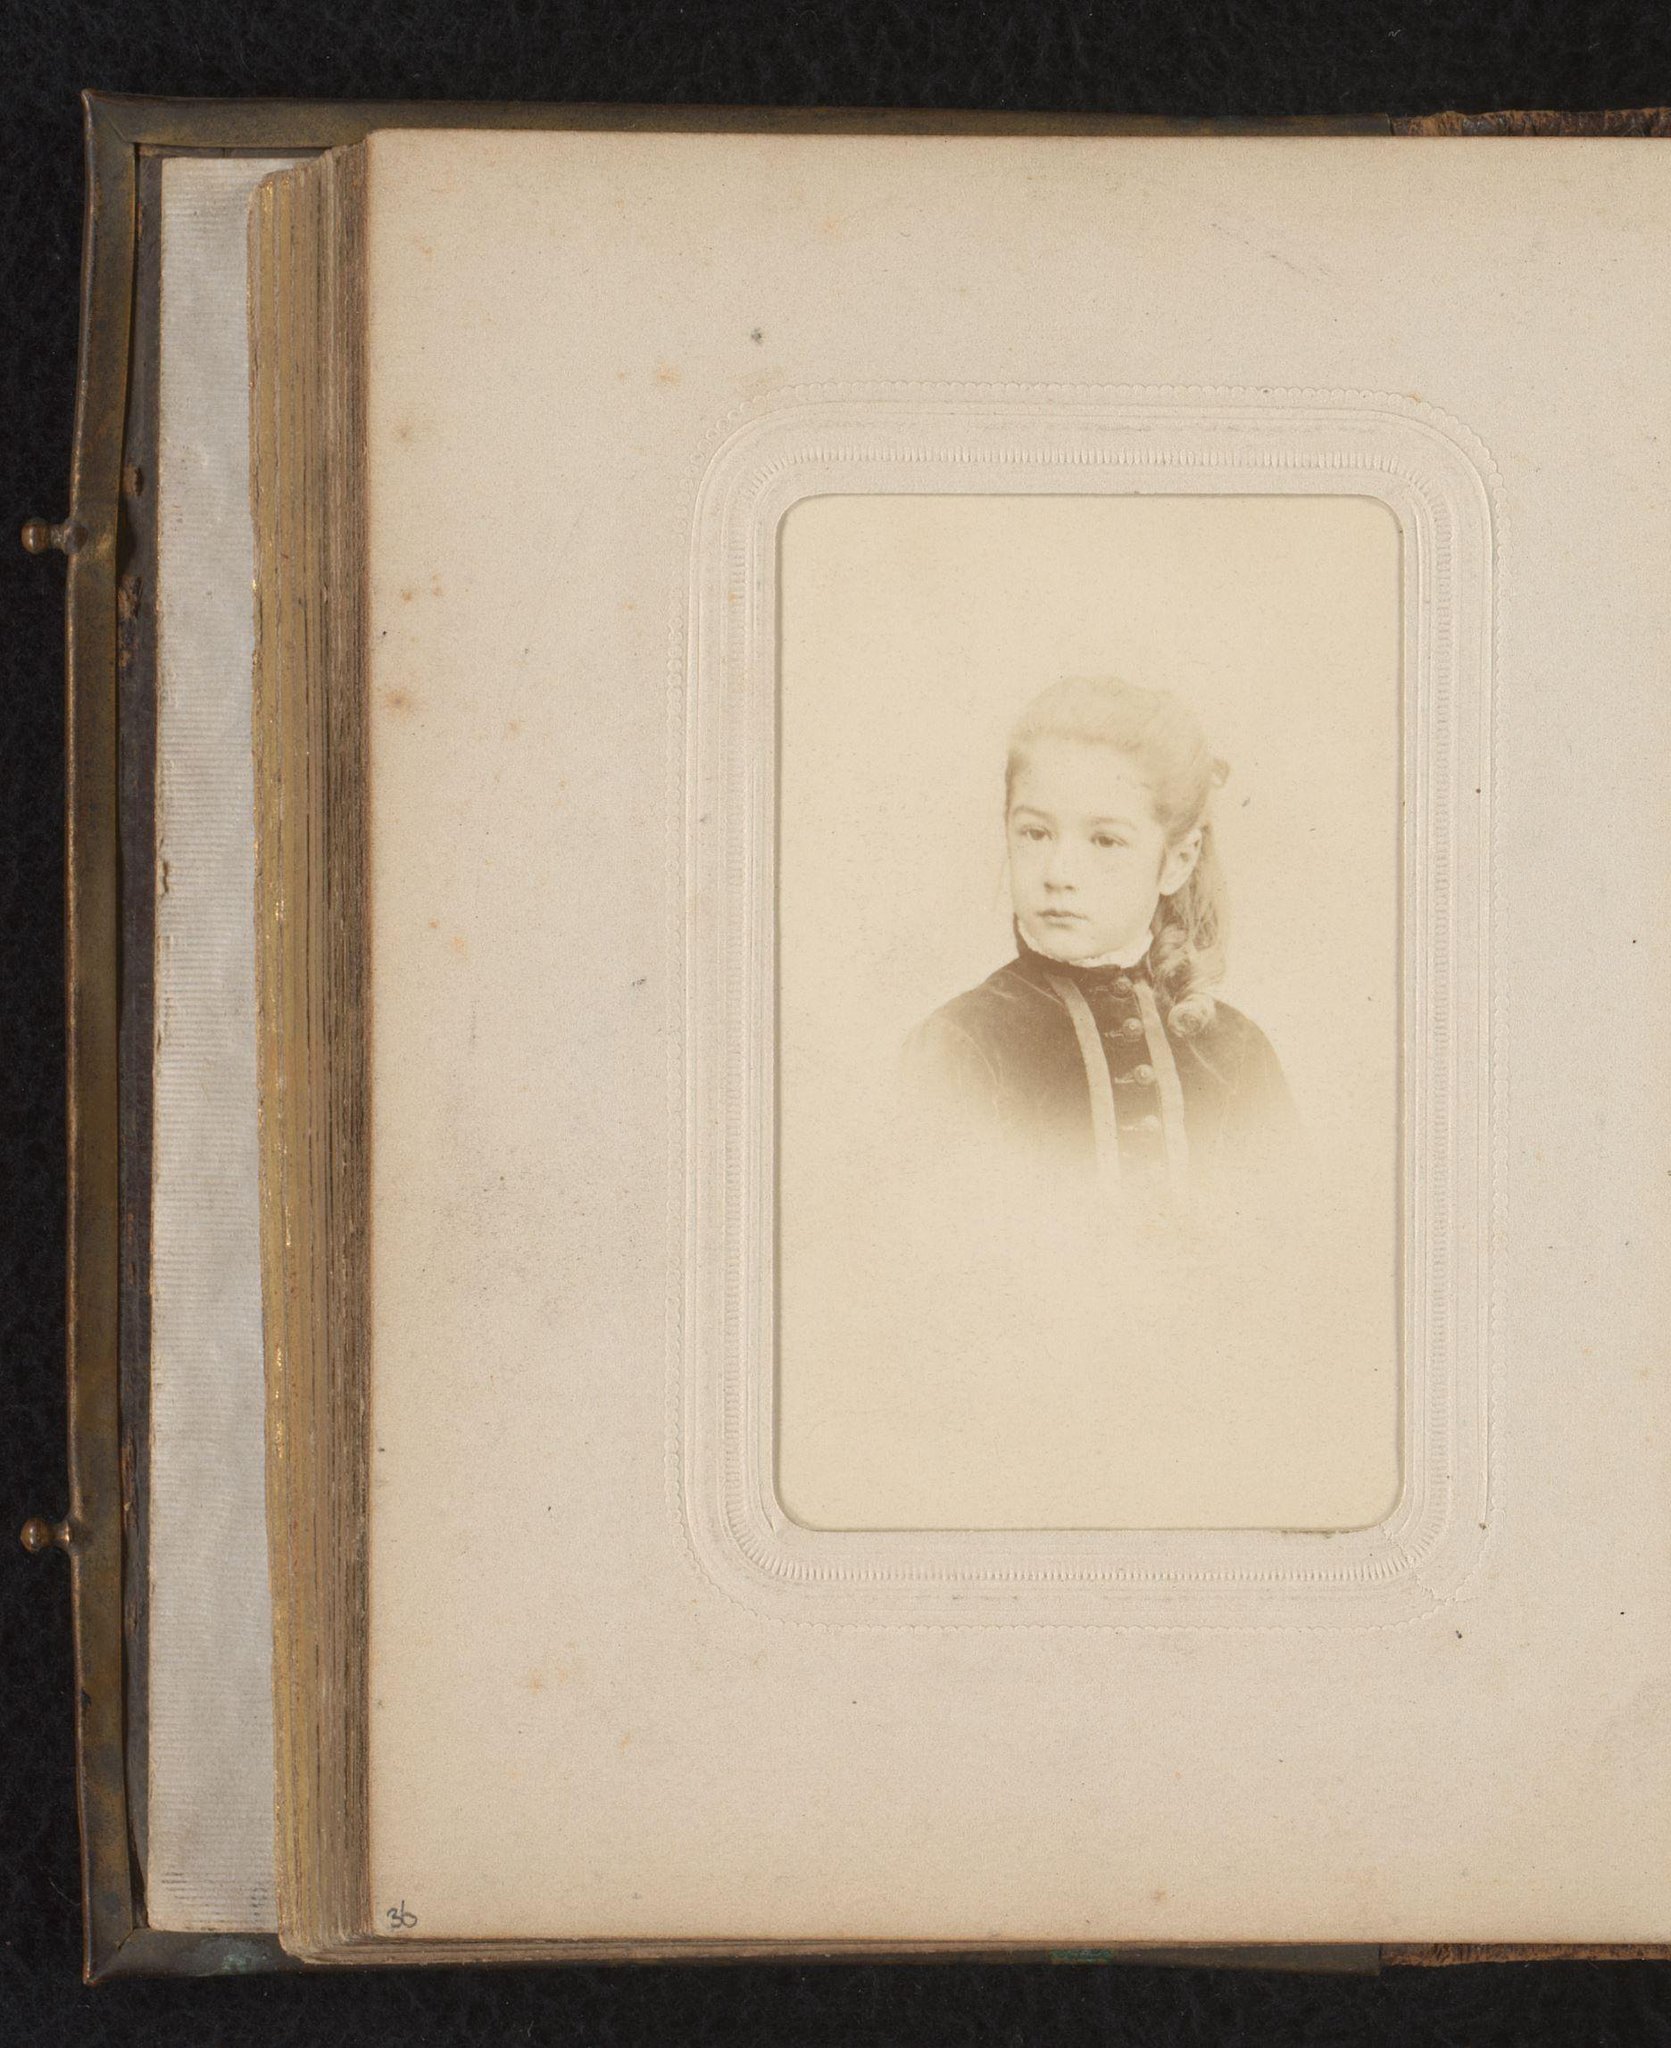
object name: photograph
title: Portret van een meisje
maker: théodore saglio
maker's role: fotograaf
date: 1860-1900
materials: cardboard, photographic support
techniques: albumen print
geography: paris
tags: historical persons - bb - woman, girl (child between toddler and youth)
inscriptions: inscription: ‘Photographie Alsacienne/ ANCIENNE MAISON/ ERWIN./ THÉODORE SAGLIO/ SUCCESSEUR/ 4, Rue Frochot, 4/ (Quartier St. Georges)/ PARIS.’